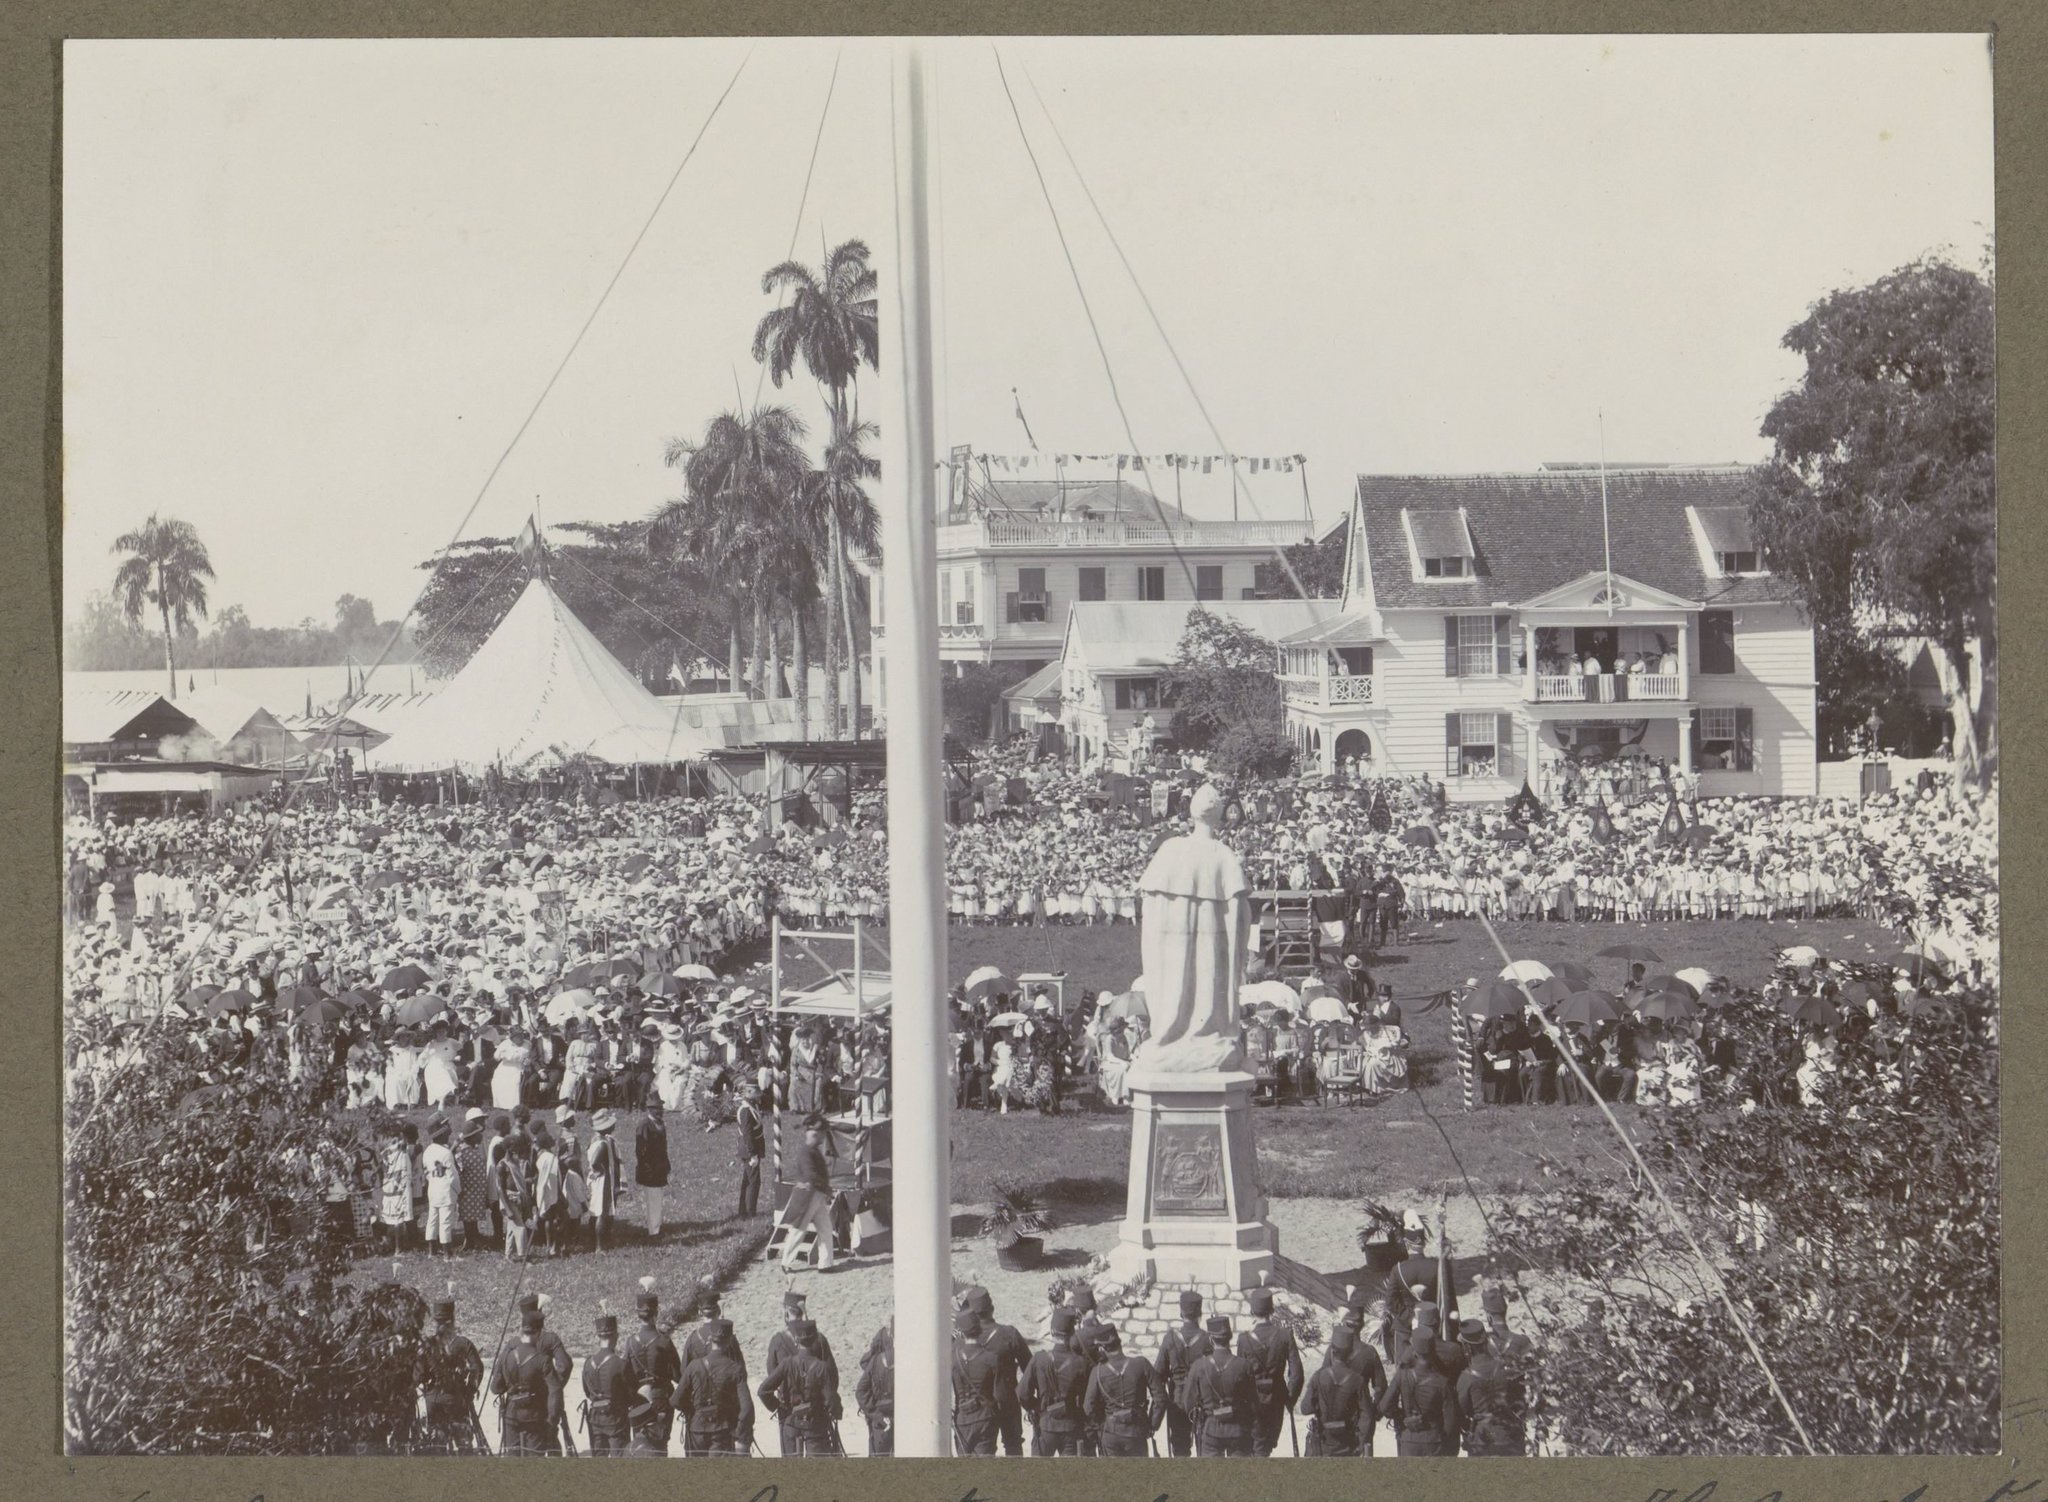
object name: photograph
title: Onthulling van een standbeeld van koningin Wilhelmina op het Gouvernementsplein te Paramaribo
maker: augusta curiel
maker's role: fotograaf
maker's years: 1873-1937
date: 1923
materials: photographic support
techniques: gelatin silver print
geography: gouvernementsplein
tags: the hague, print maker, wilhelmina of the netherlands, public festivities on the occasion of royal events, monument, statue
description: Onderdeel van fotoalbum van een onbekende Nederlandse familie met opnames van Suriname, Europa en Nederlands-Indië.